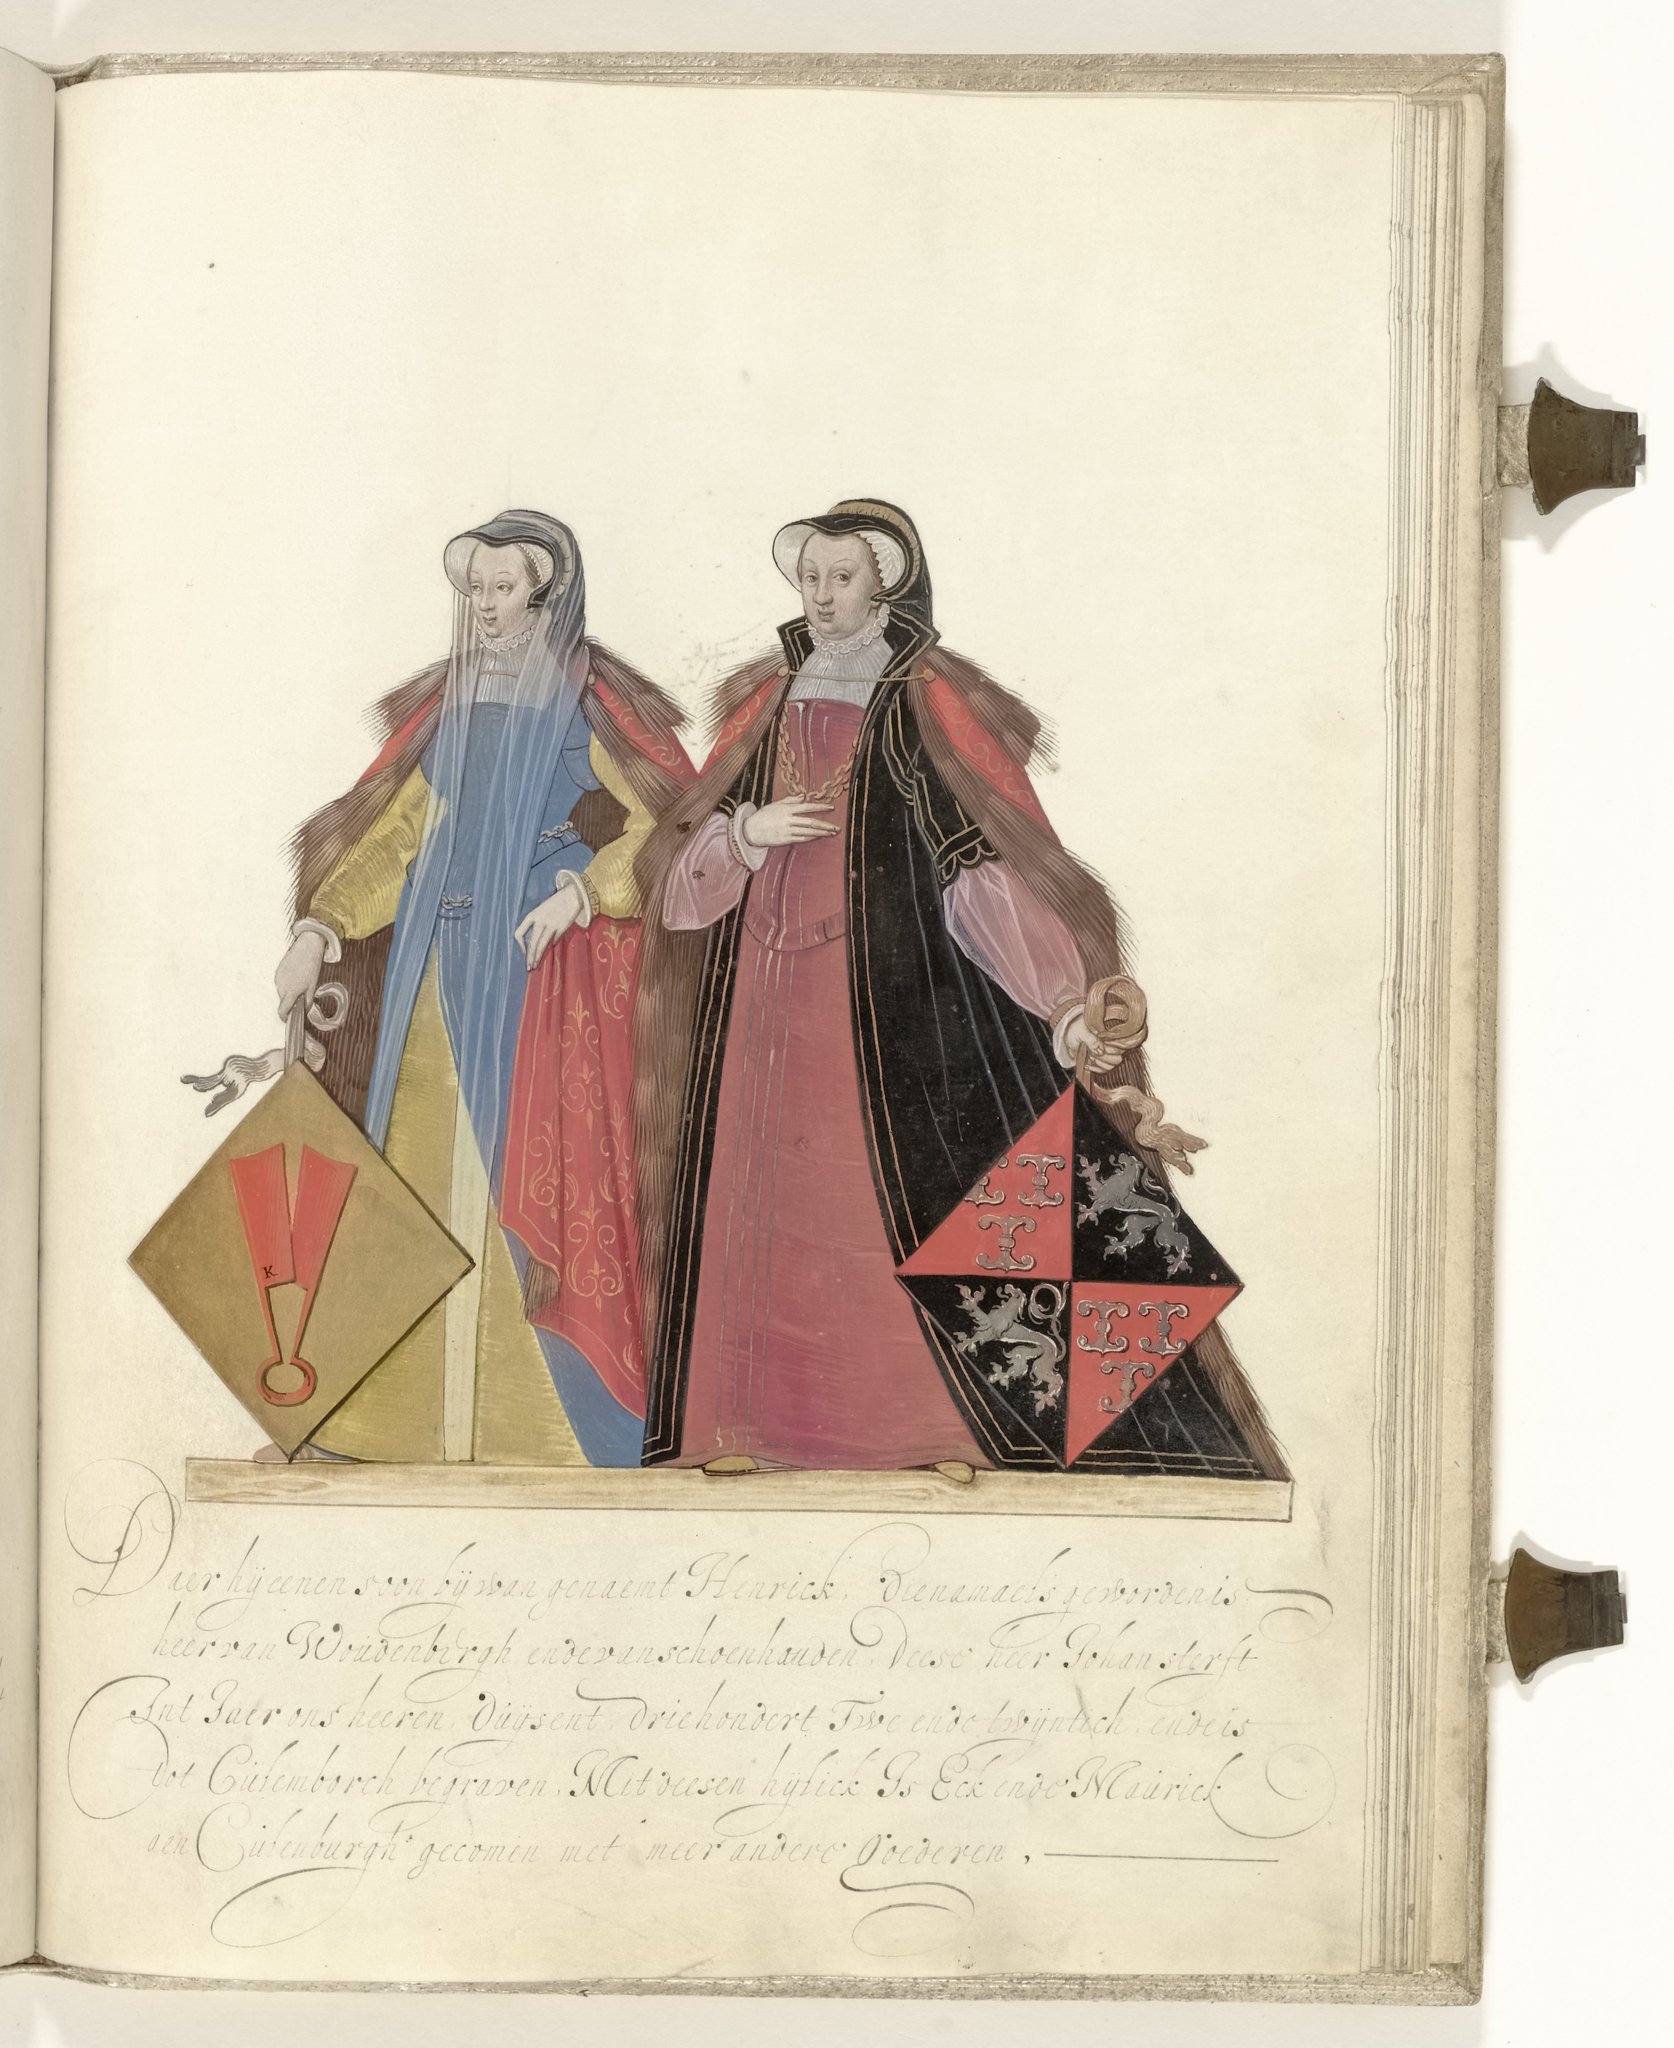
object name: drawing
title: Twee vrouwen van Culemborg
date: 1590-1593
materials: paint, gouache, ink, parchment, watercolor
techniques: writing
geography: northern netherlands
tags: culemborg, heren en graven van, margaretha van maurik vrouwe van culemborg, petronella van abcoude vrouwe van culemborg, culemborg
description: Margaretha van Maurik en Petronella van Abcoude, de eerste en tweede vrouw van Johan, heer van Culemborg. Twee vrouwen, staande naast elkaar ten voeten uit. Met het wapen van Maurik en een gevierendeeld wapen van Abcoude met Culemborg. Onderdeel van een geïllustreerd handschrift met de genealogie van de heren en graven van Culemborg.